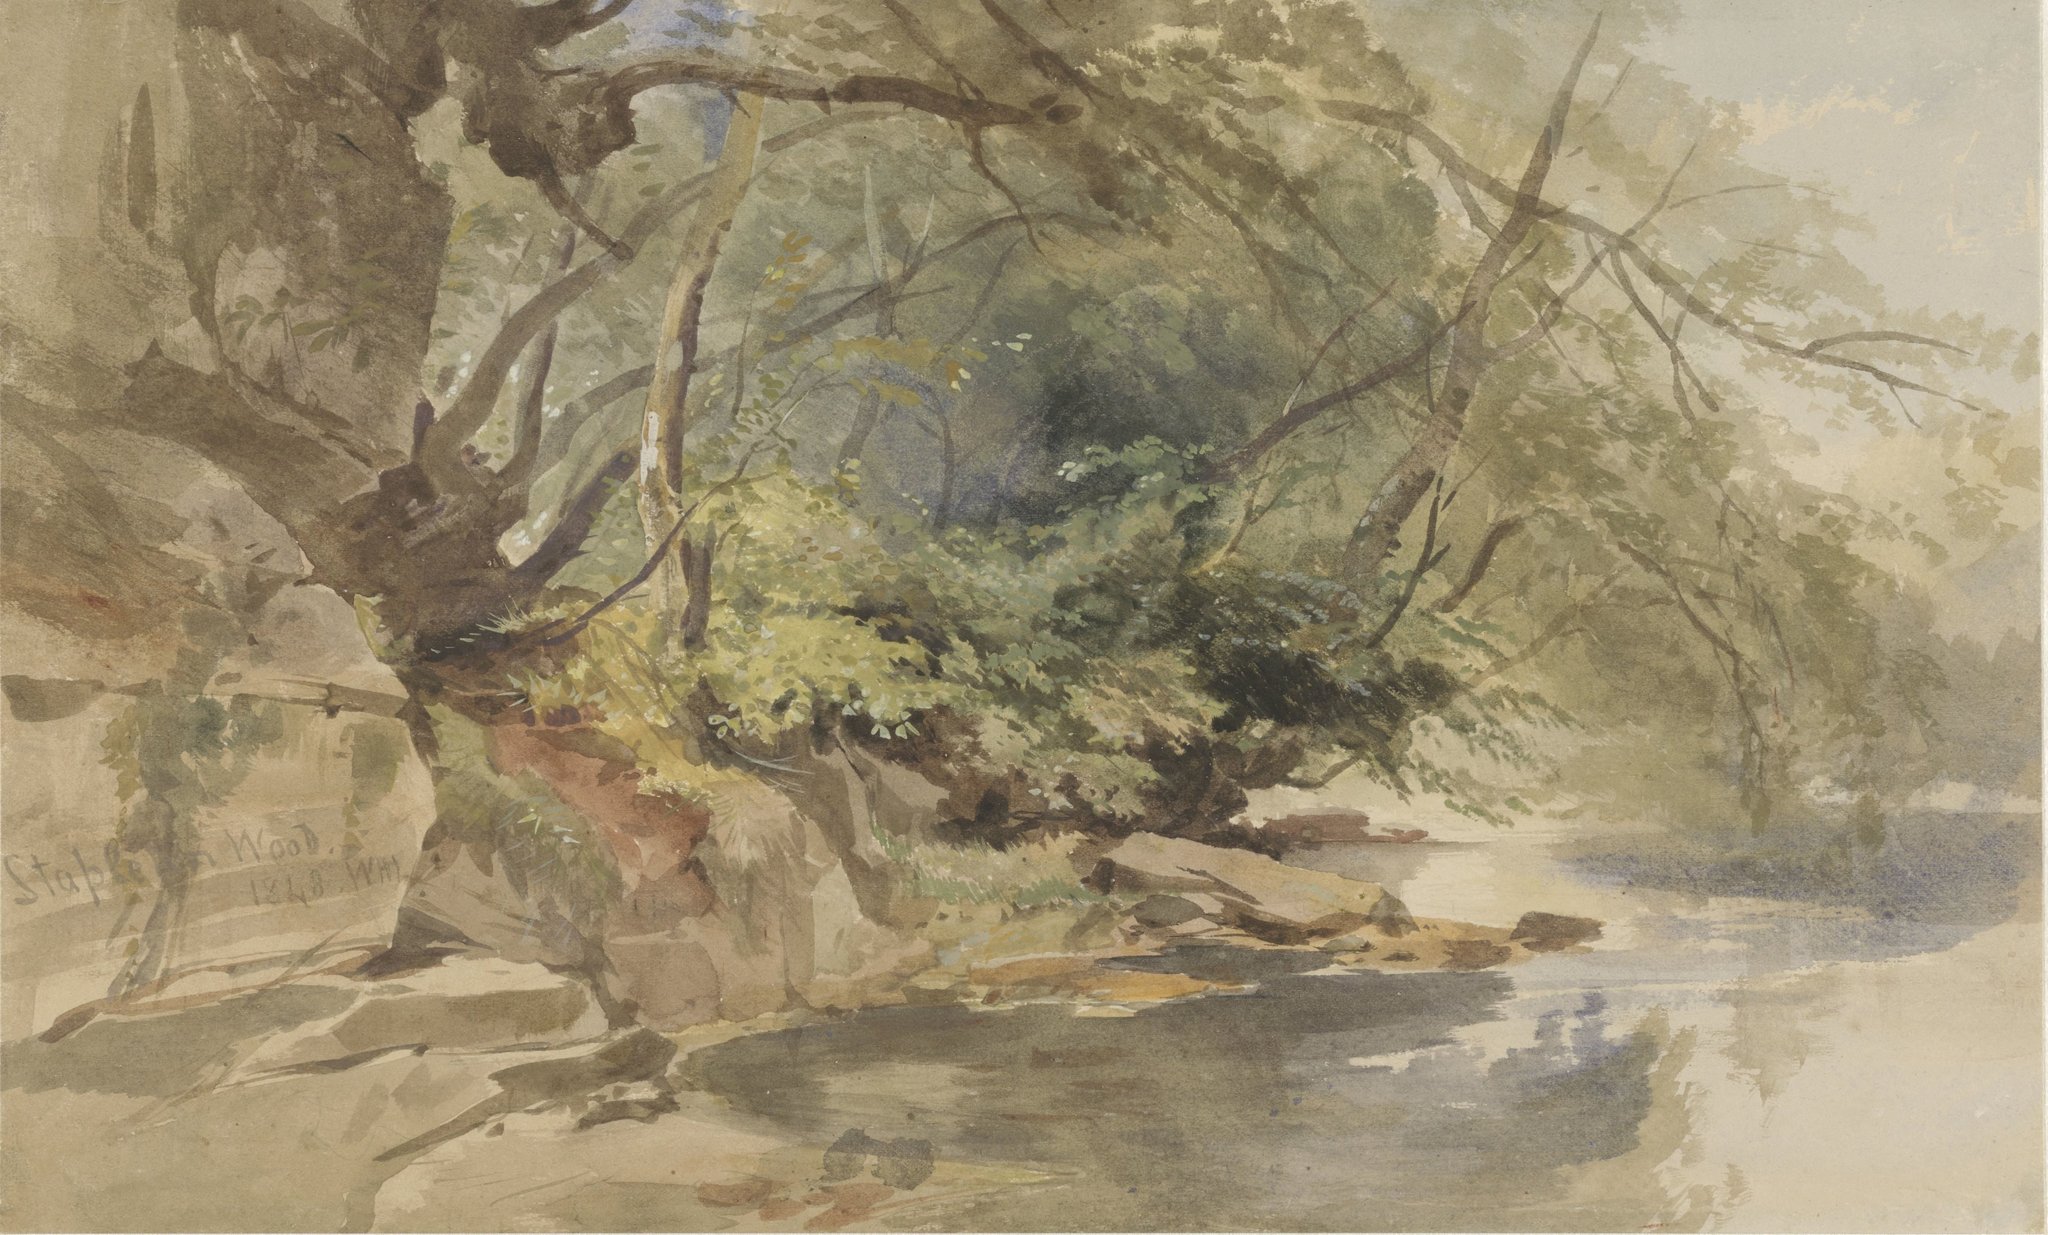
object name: drawing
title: Gezicht in Stapleton Wood, bij Bristol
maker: william james muller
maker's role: draughtsman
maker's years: 1812-1845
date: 1843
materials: paper, watercolor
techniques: brush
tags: park, forest, wood, brook